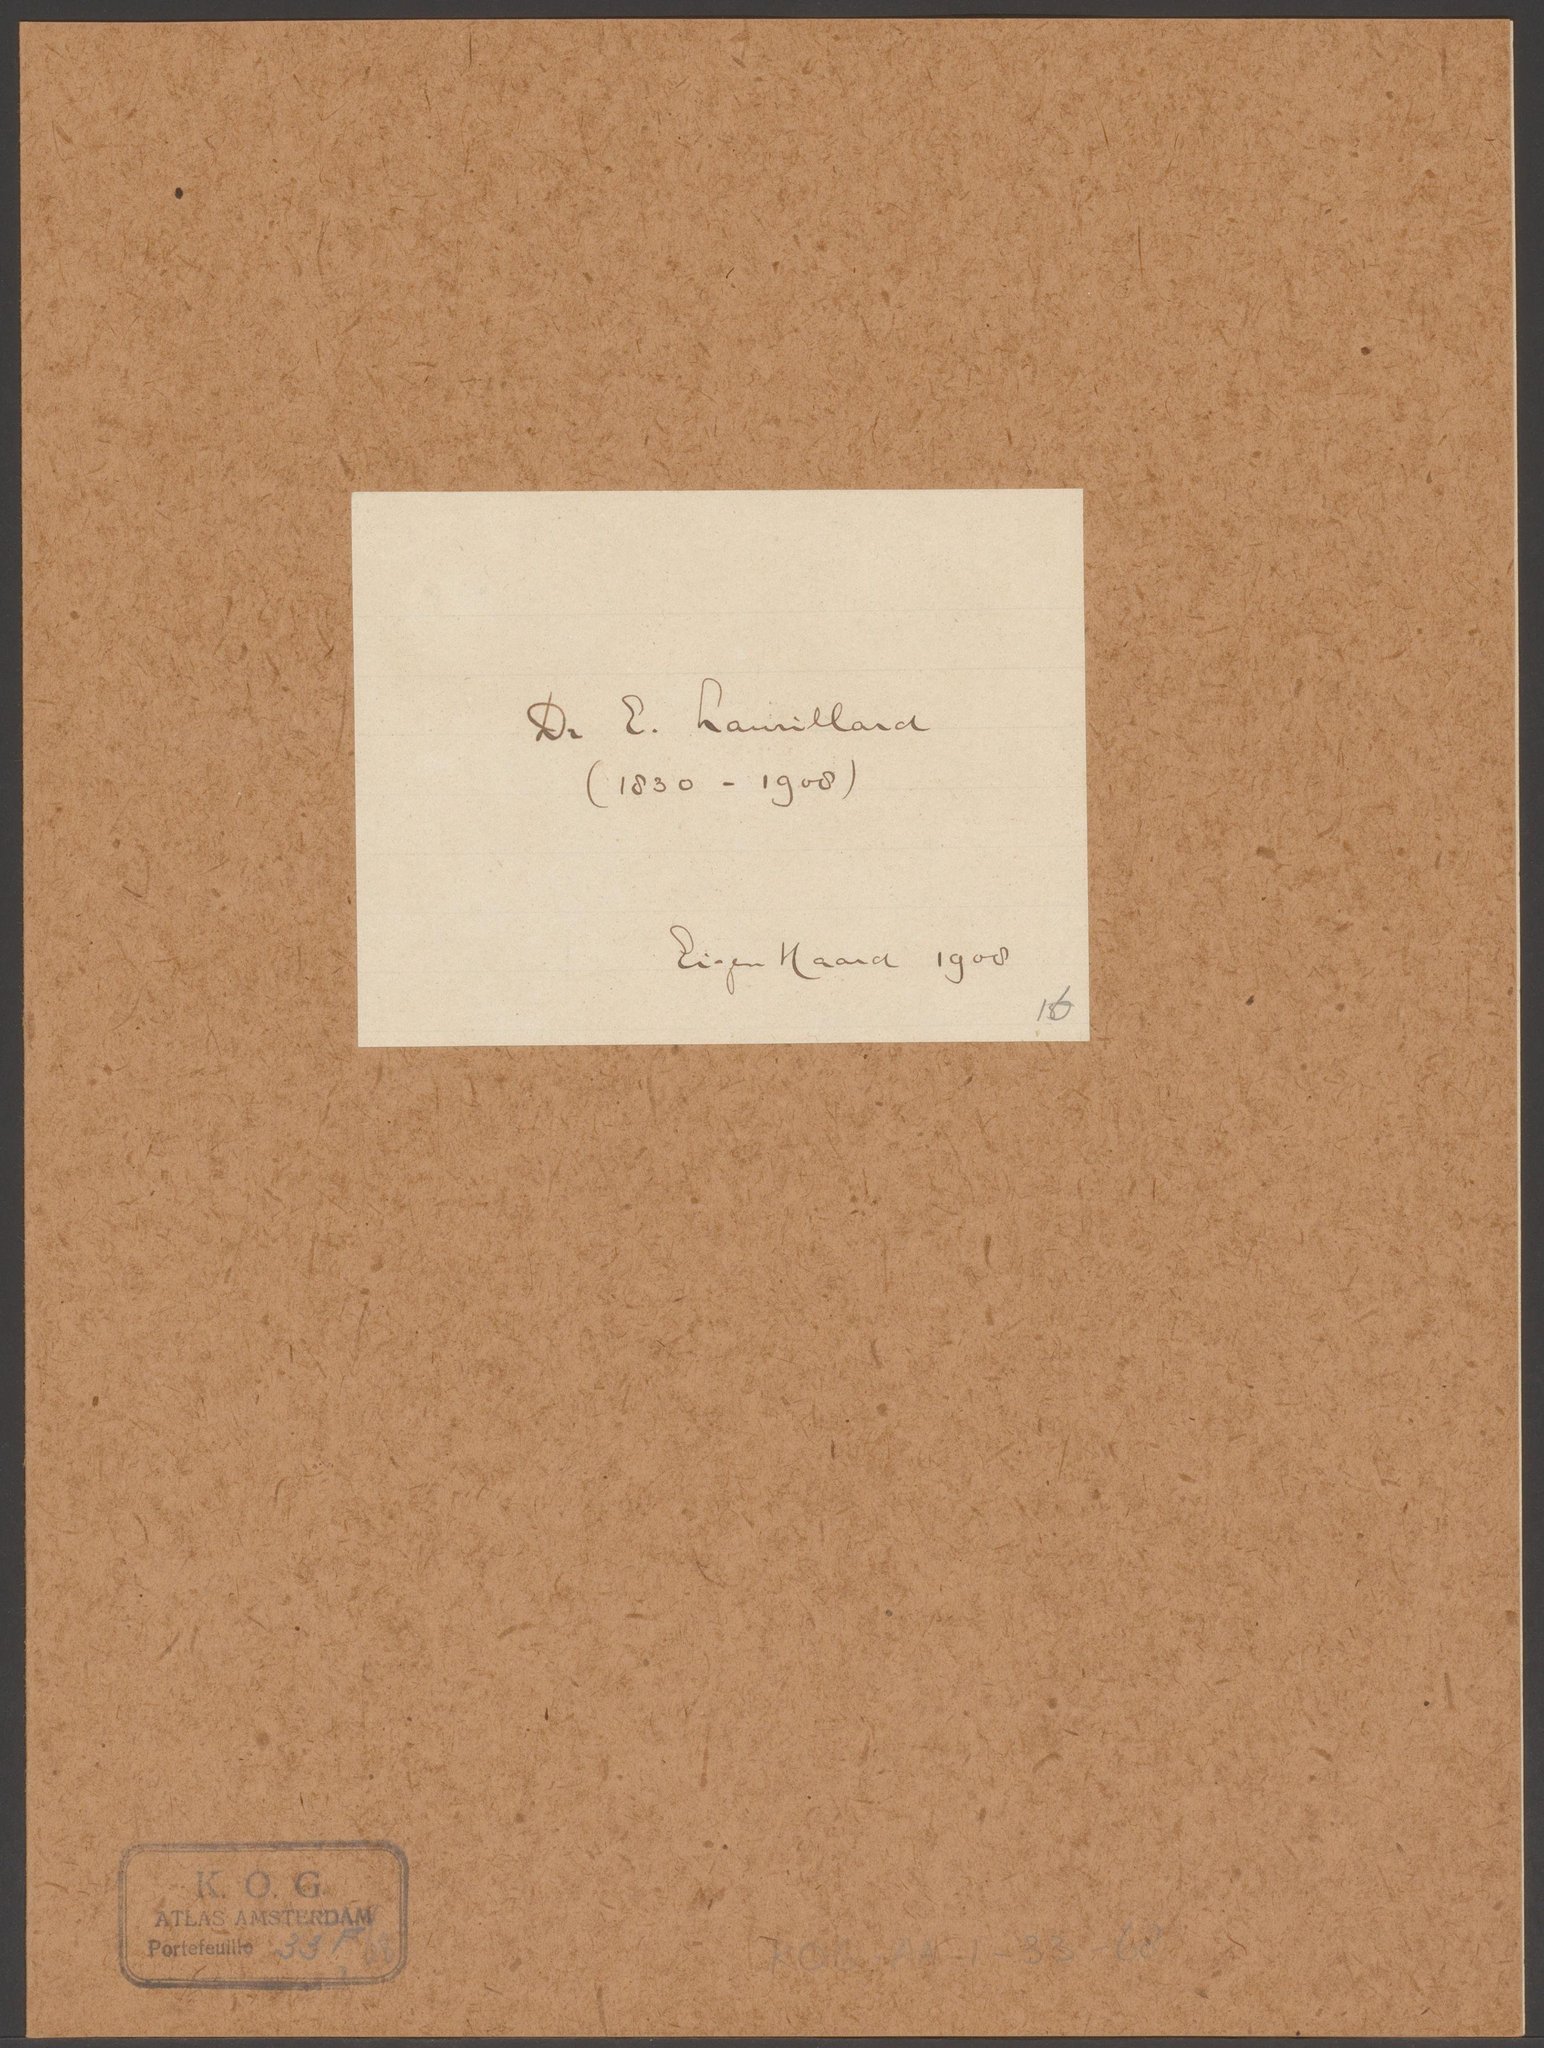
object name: photomechanical print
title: Portret van Eliza Laurillard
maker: Anonymous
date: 1908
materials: paper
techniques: letterpress printing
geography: amsterdam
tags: rotterdam, eliza laurillard, historical persons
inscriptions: collector's mark: Lugt 1641b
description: Object in een bruine omslag geplakt. Onderwerpsrubriek binnen de Atlas Amsterdam: Kerkwezen: Hervormde Gemeente: Herinneringen aan hervormde predikanten.